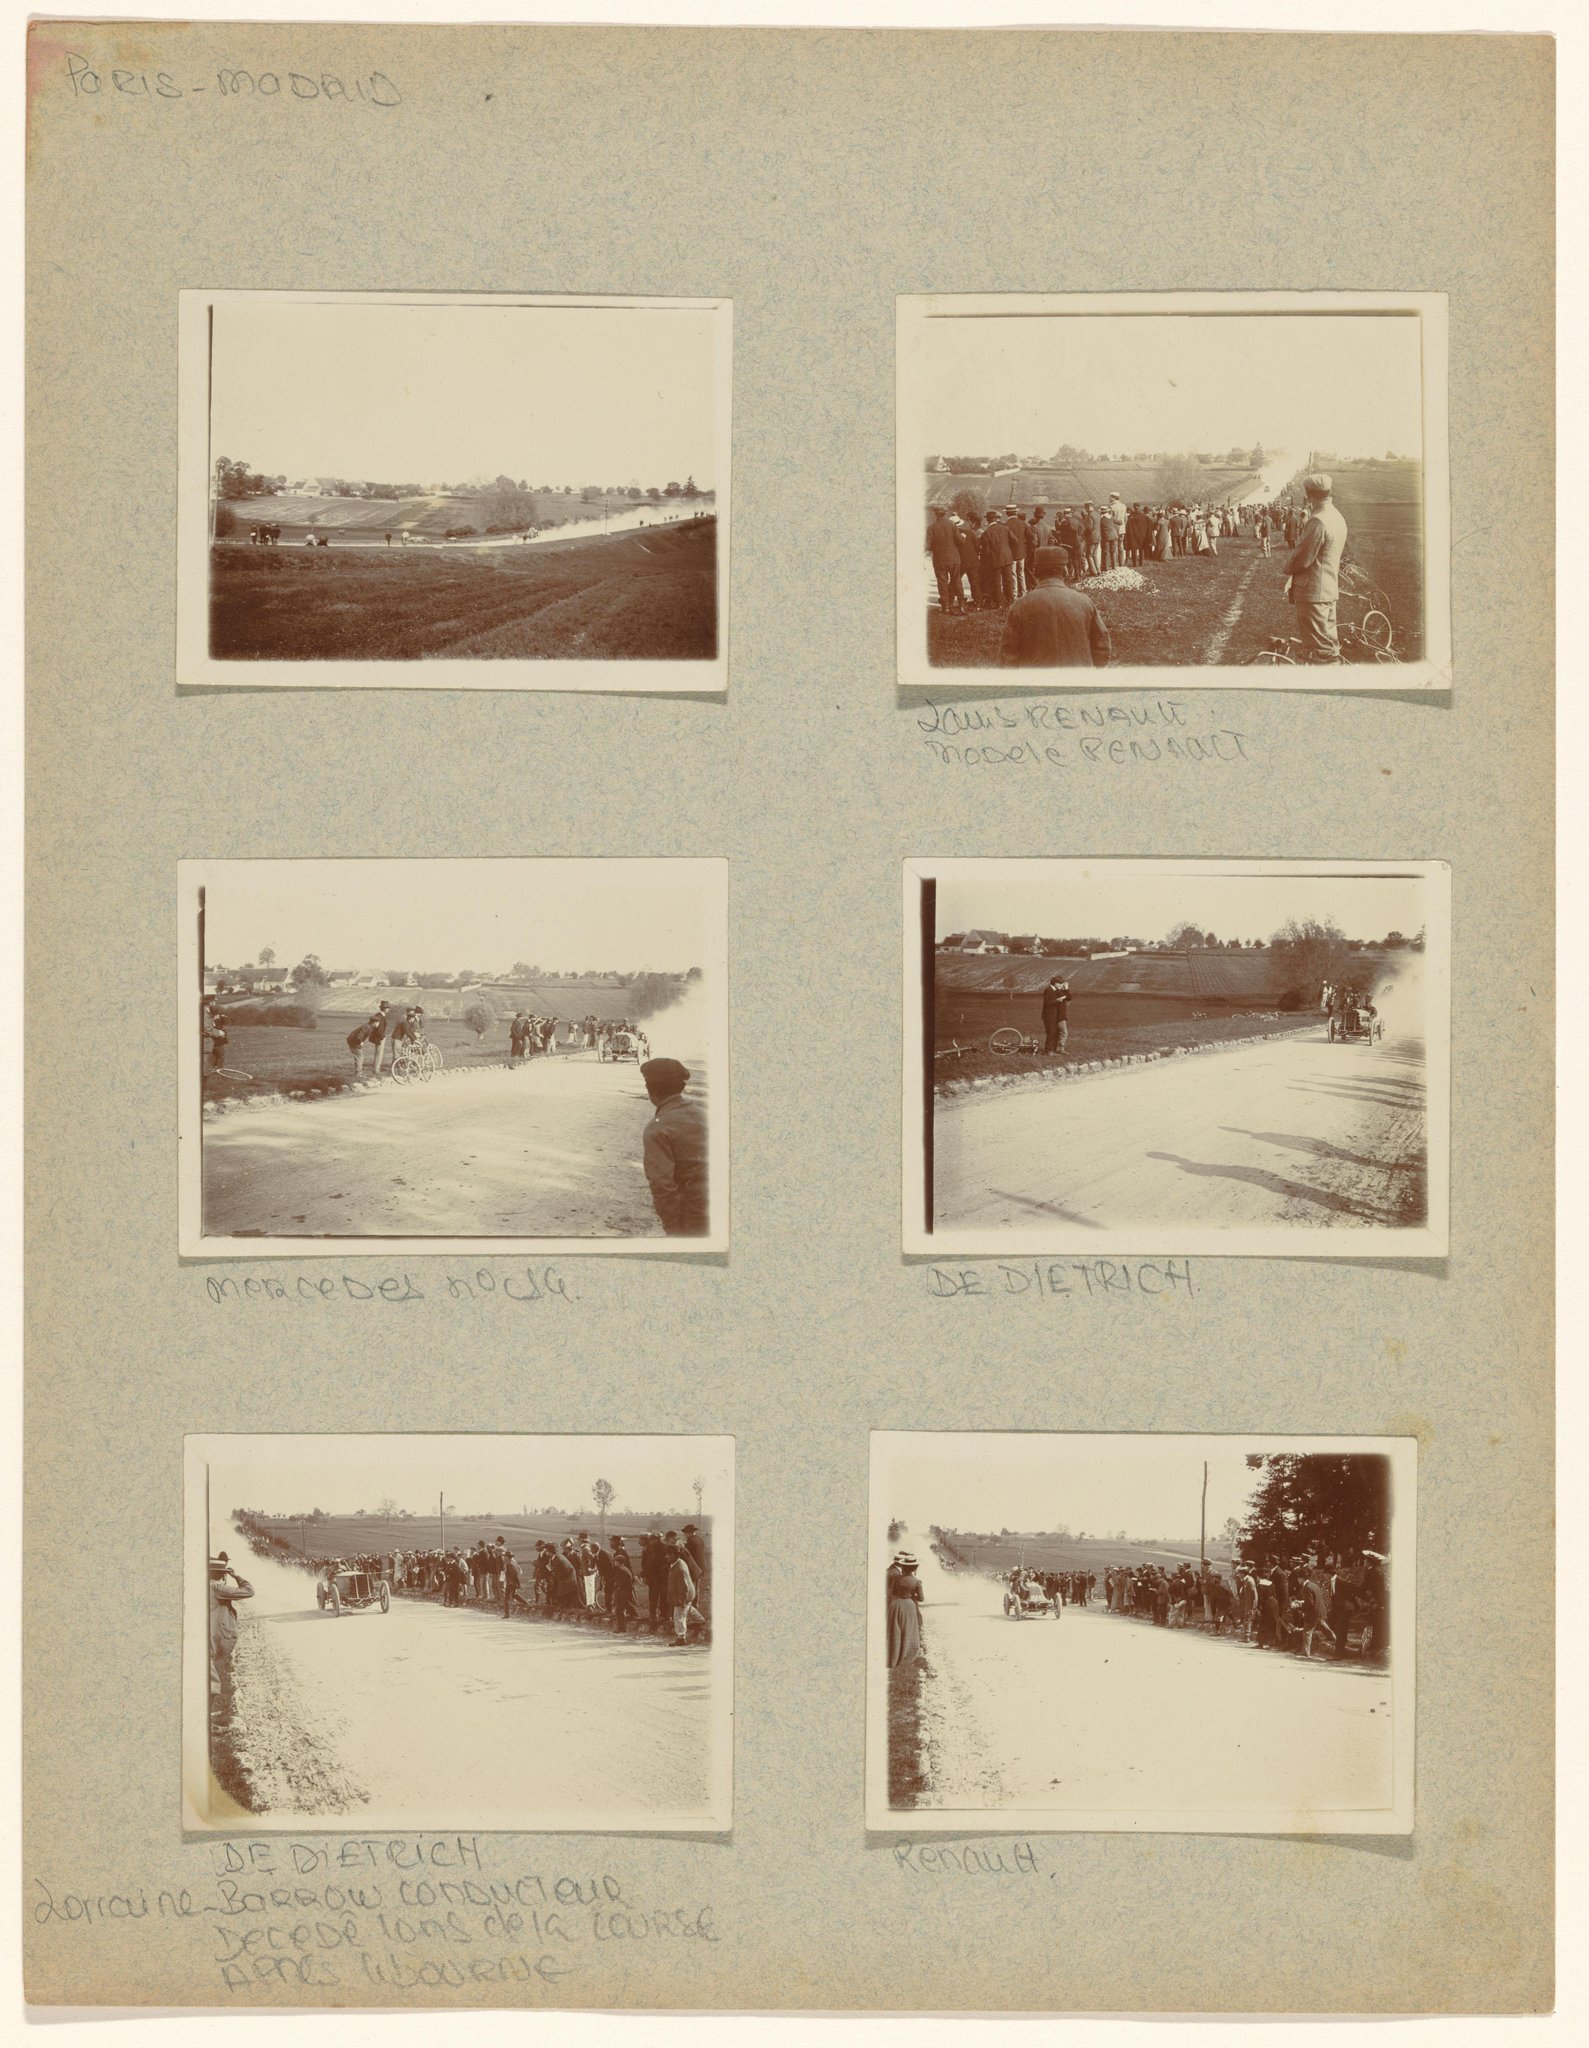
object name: album leaf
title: Albumblad met zes foto’s van de autorace tussen Parijs en Madrid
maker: Anonymous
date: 1903-1905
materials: paper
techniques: gelatin silver print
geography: france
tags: motorcar racing, france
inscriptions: inscription: ‘Paris-Madrid (...) après Ubourne’